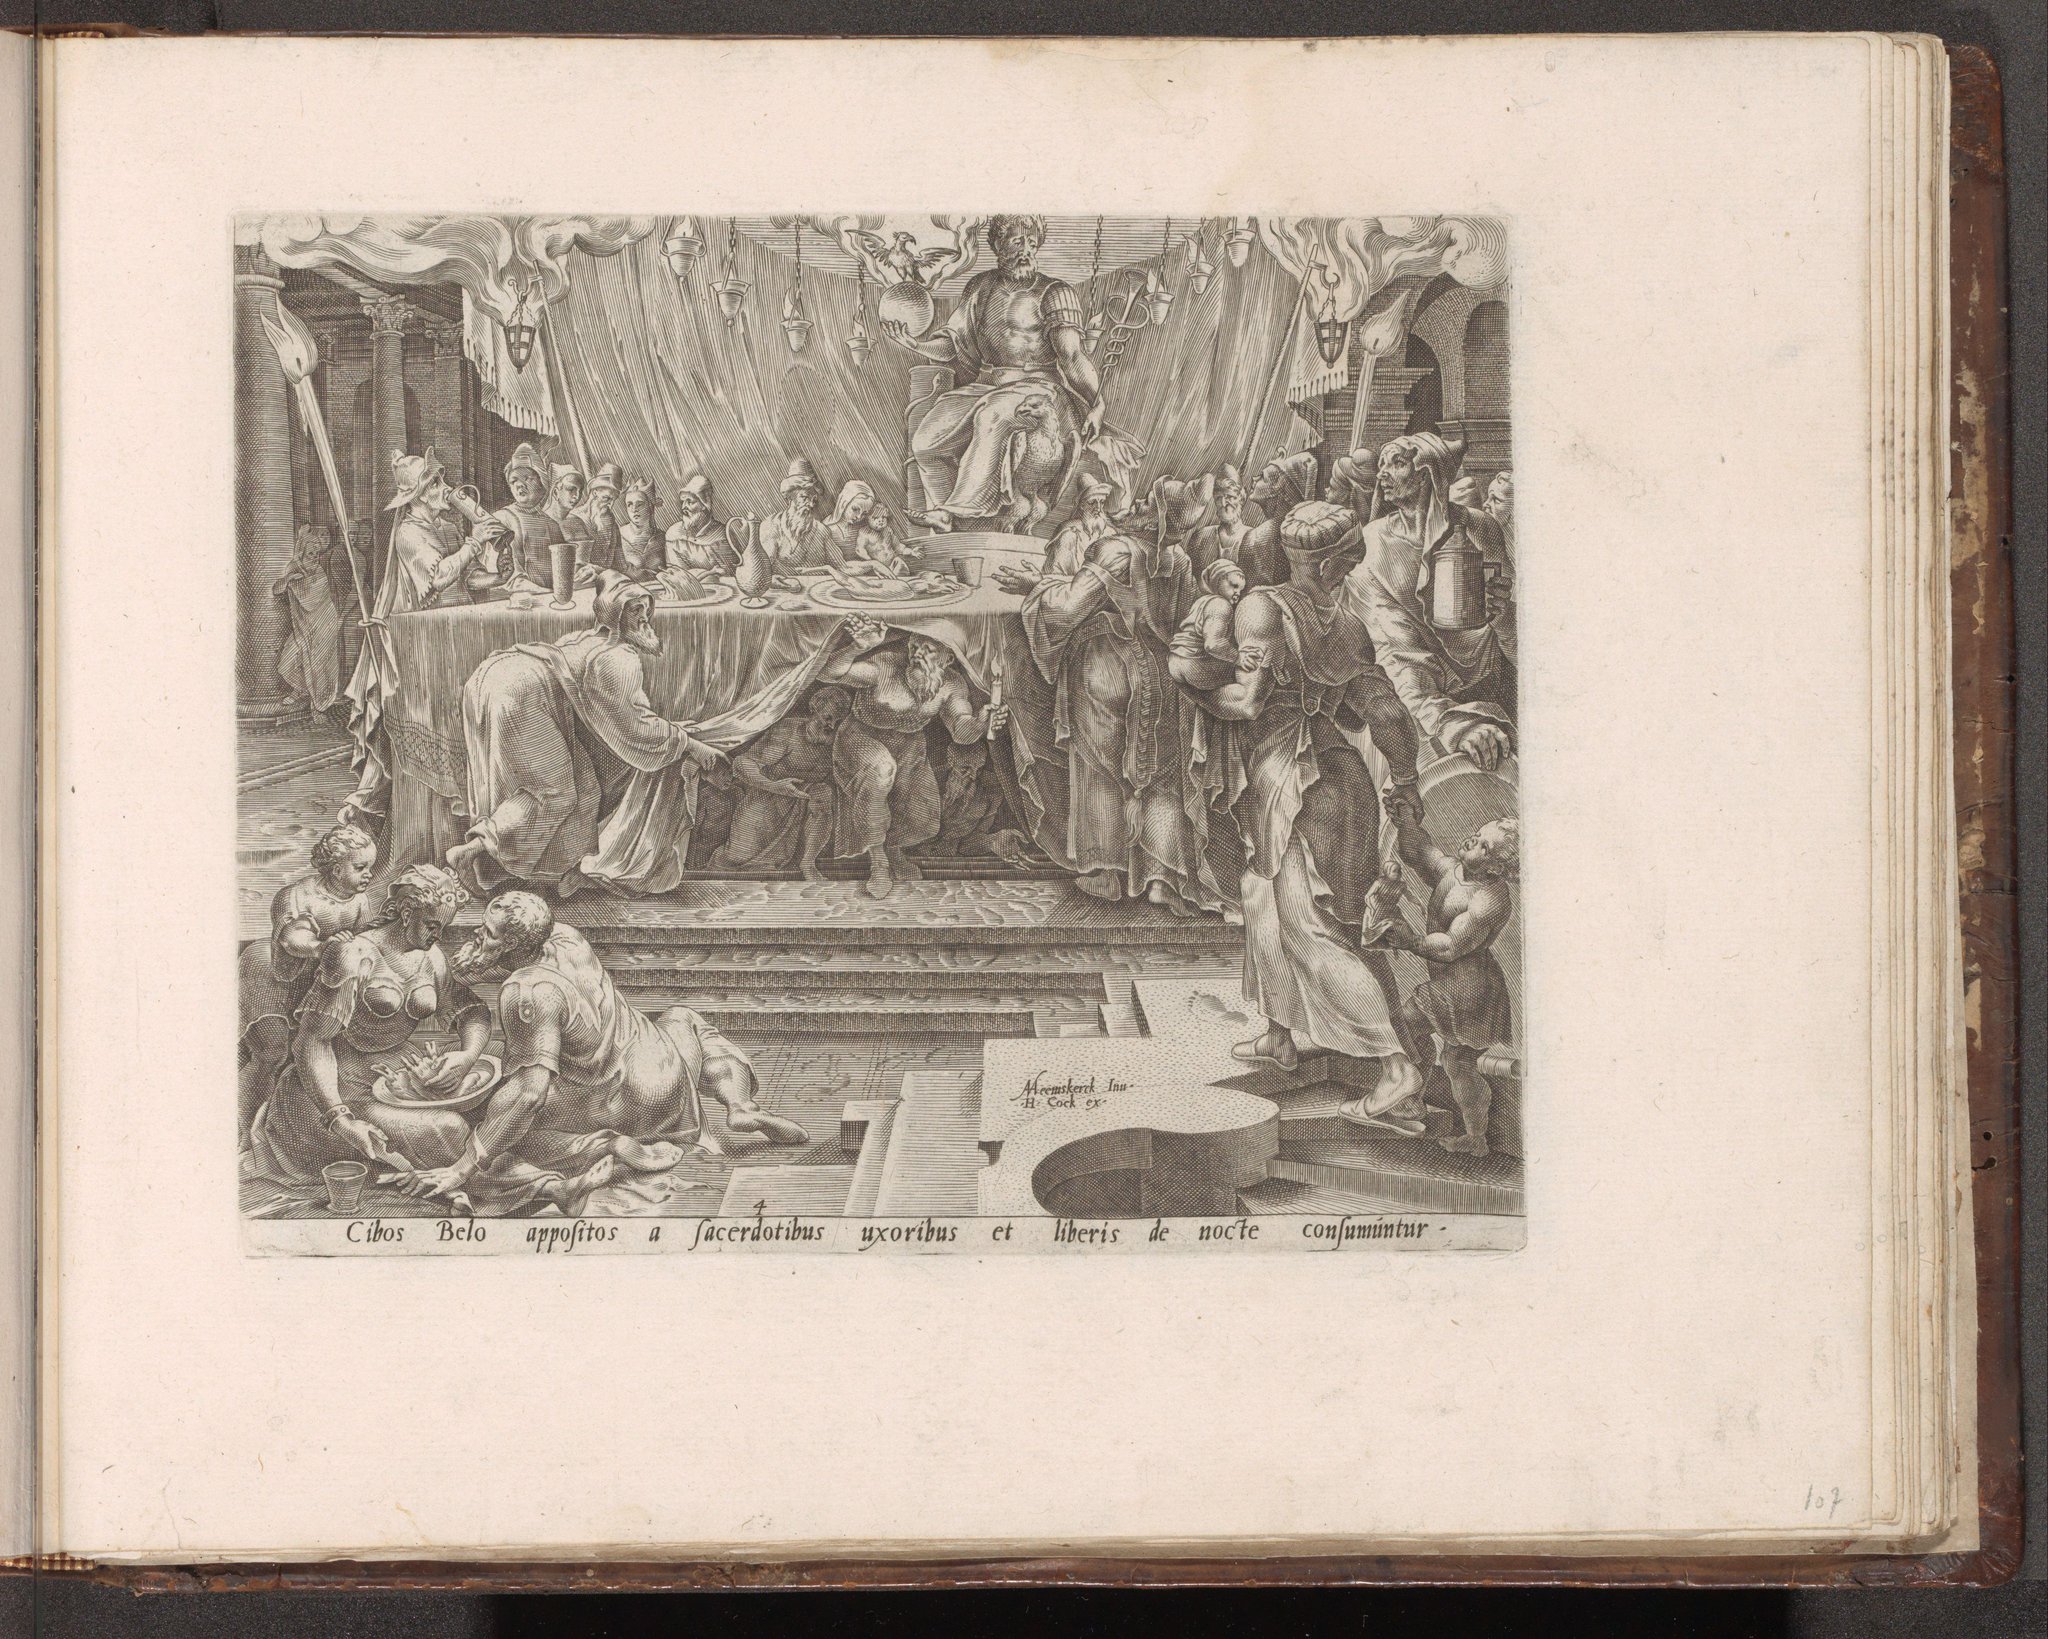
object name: print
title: Thesaurus sacrarum historiaru[m] veteris testame[n]ti, elega[n]tissimis imaginibus expressu[m] excelle[n]tissimoru[m] in hac arte viroru[m] opera: nu[n]c primu[m] in luce[m] editus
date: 1565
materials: paper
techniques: engraving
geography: antwerp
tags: the priests of bel, with their wives and children, enter the temple through a hidden corridor and feast on the food during the night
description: De priesters van Bel eten het aan de god Bel geofferde voedsel. Ze komen en gaan door een geheime gang onder de tafel. Terwijl ze heimelijk het voedsel nemen, blijven hun voetstappen achter in de door Daniël op de grond gestrooide as. Onder de voorstelling een verklarende tekst in het Latijn. Prent maakt deel uit van een album.